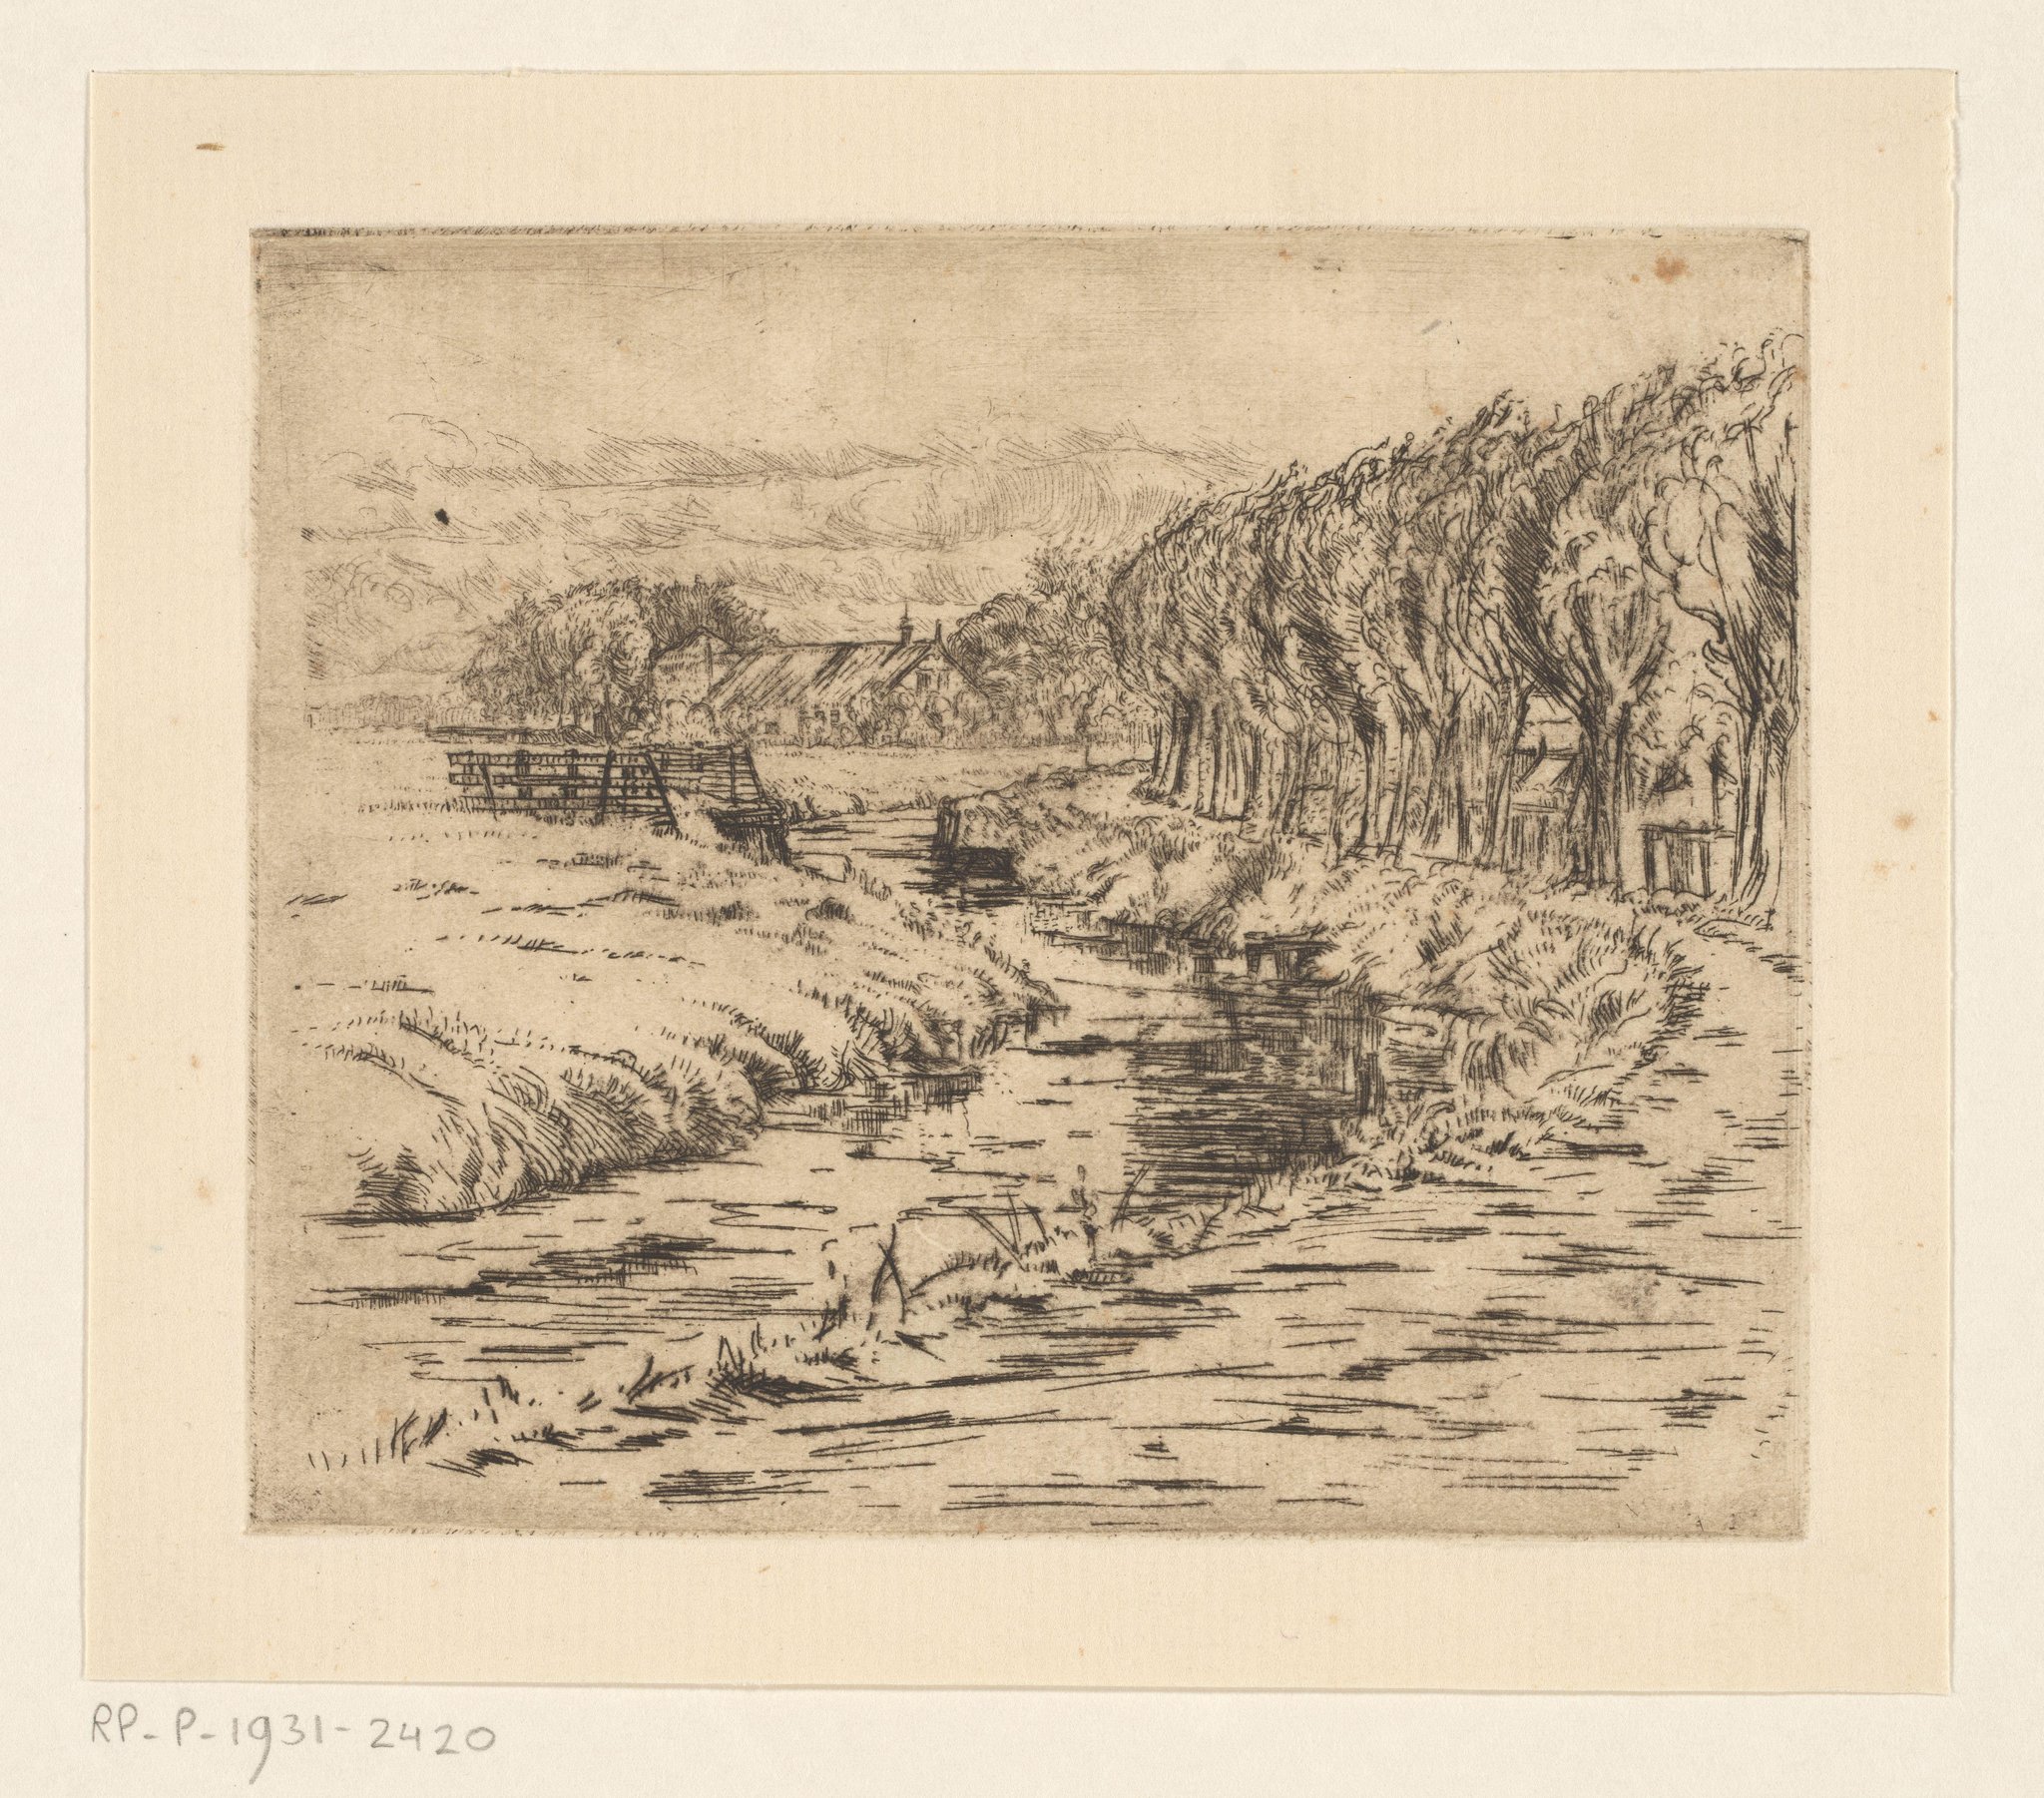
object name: print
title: Landschap met sloot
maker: johannes löhr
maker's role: print maker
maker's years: 1882-1928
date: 1892-1928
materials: paper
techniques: etching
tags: small canal, ditch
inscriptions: collector's mark: Lugt 2228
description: Rechts langs de sloot een rij bomen. Op de achtergrond een boerderij.